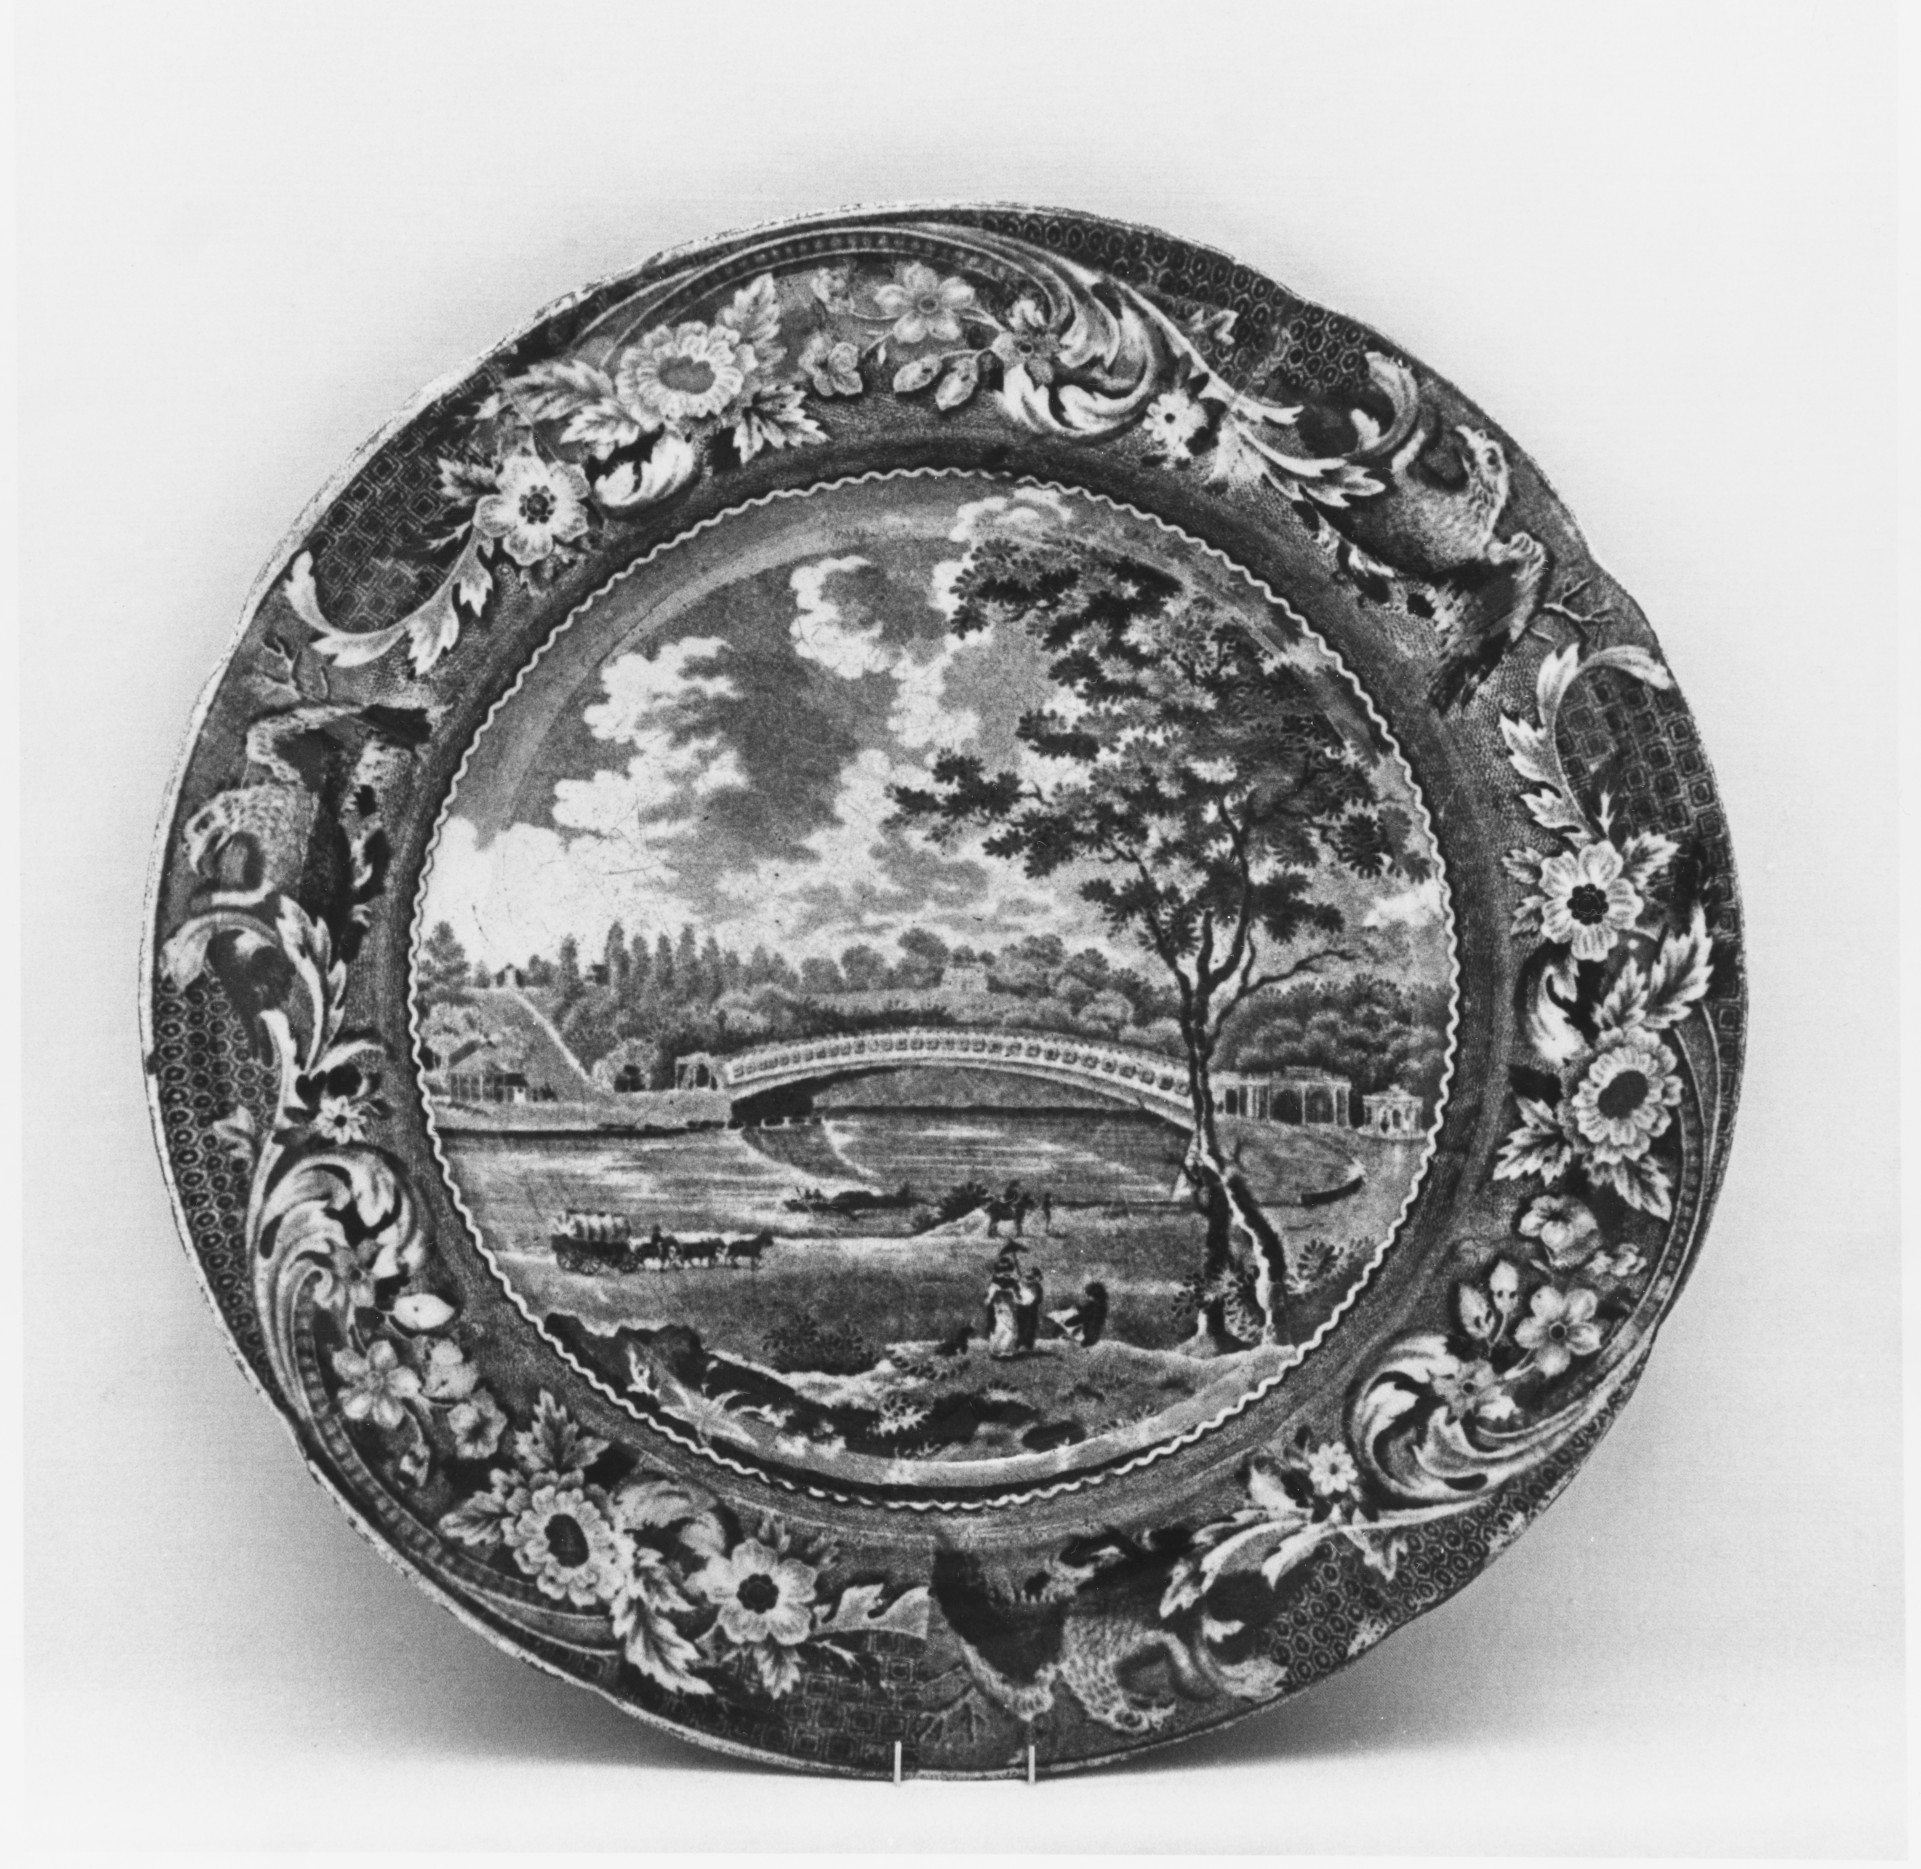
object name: plate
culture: british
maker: joseph stubbs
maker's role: maker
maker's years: 1819-1836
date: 1824-1836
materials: earthenware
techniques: transfer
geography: england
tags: landscapes